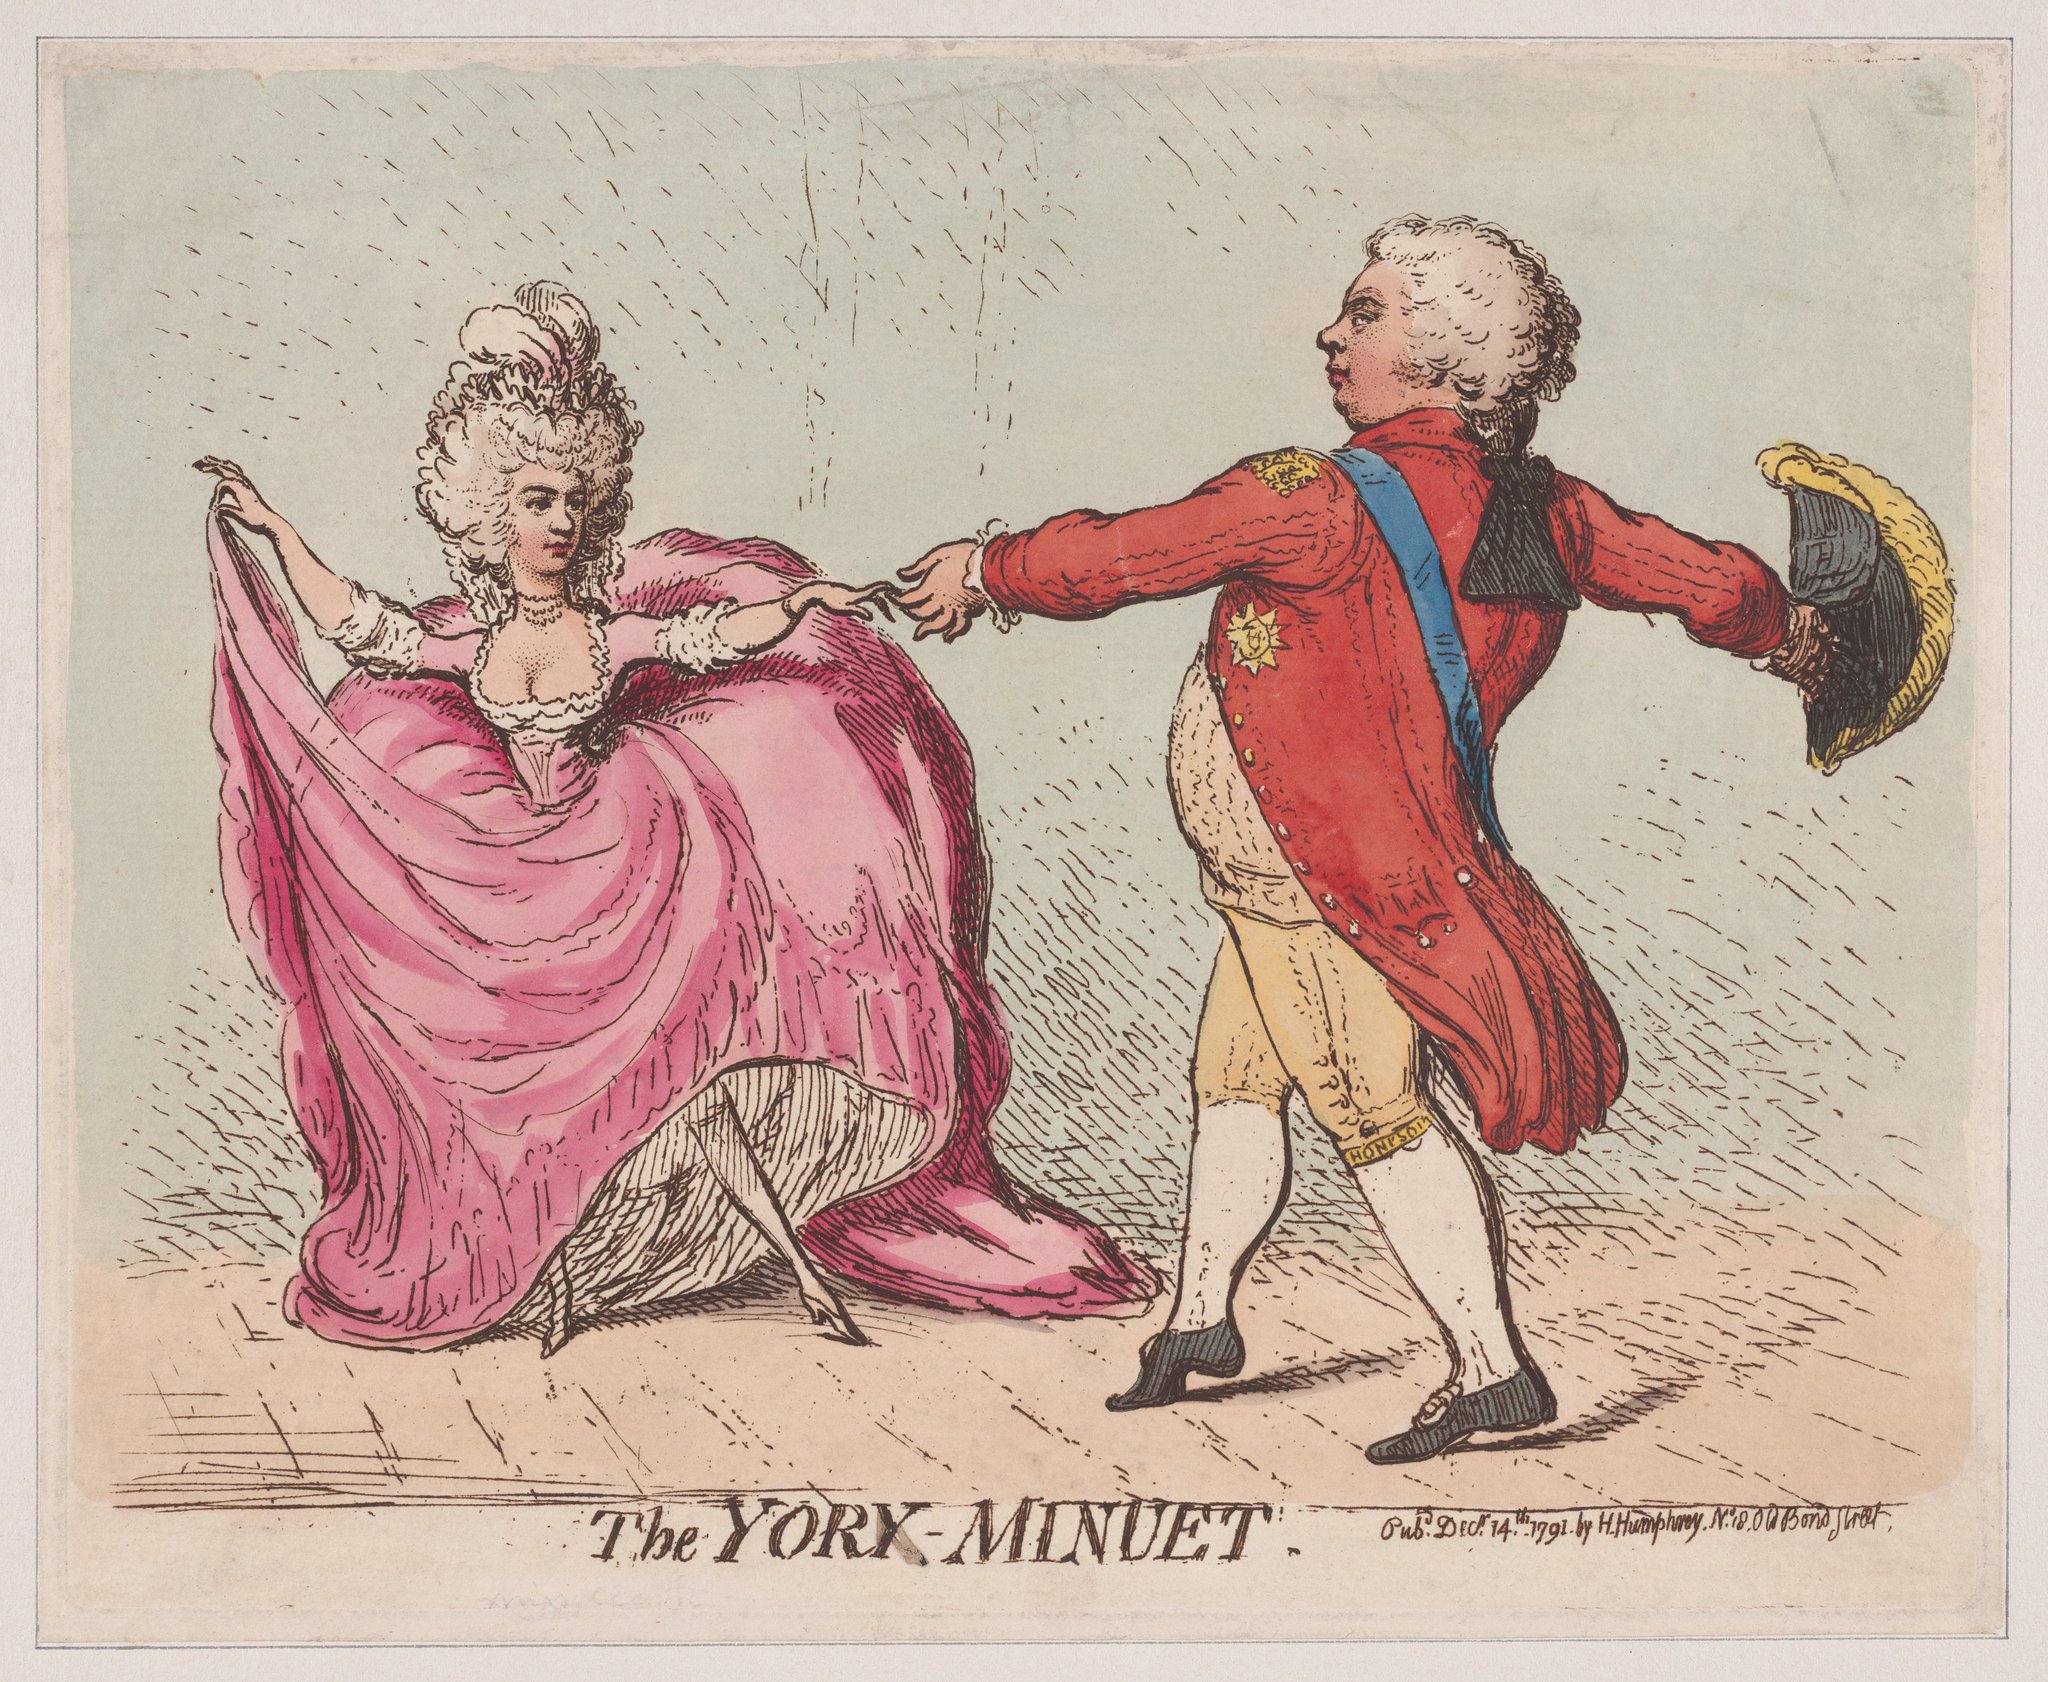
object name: print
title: The York-Minuet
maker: james gillray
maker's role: artist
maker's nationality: british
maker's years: 1756-1815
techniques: etching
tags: men,women,dancing,caricature